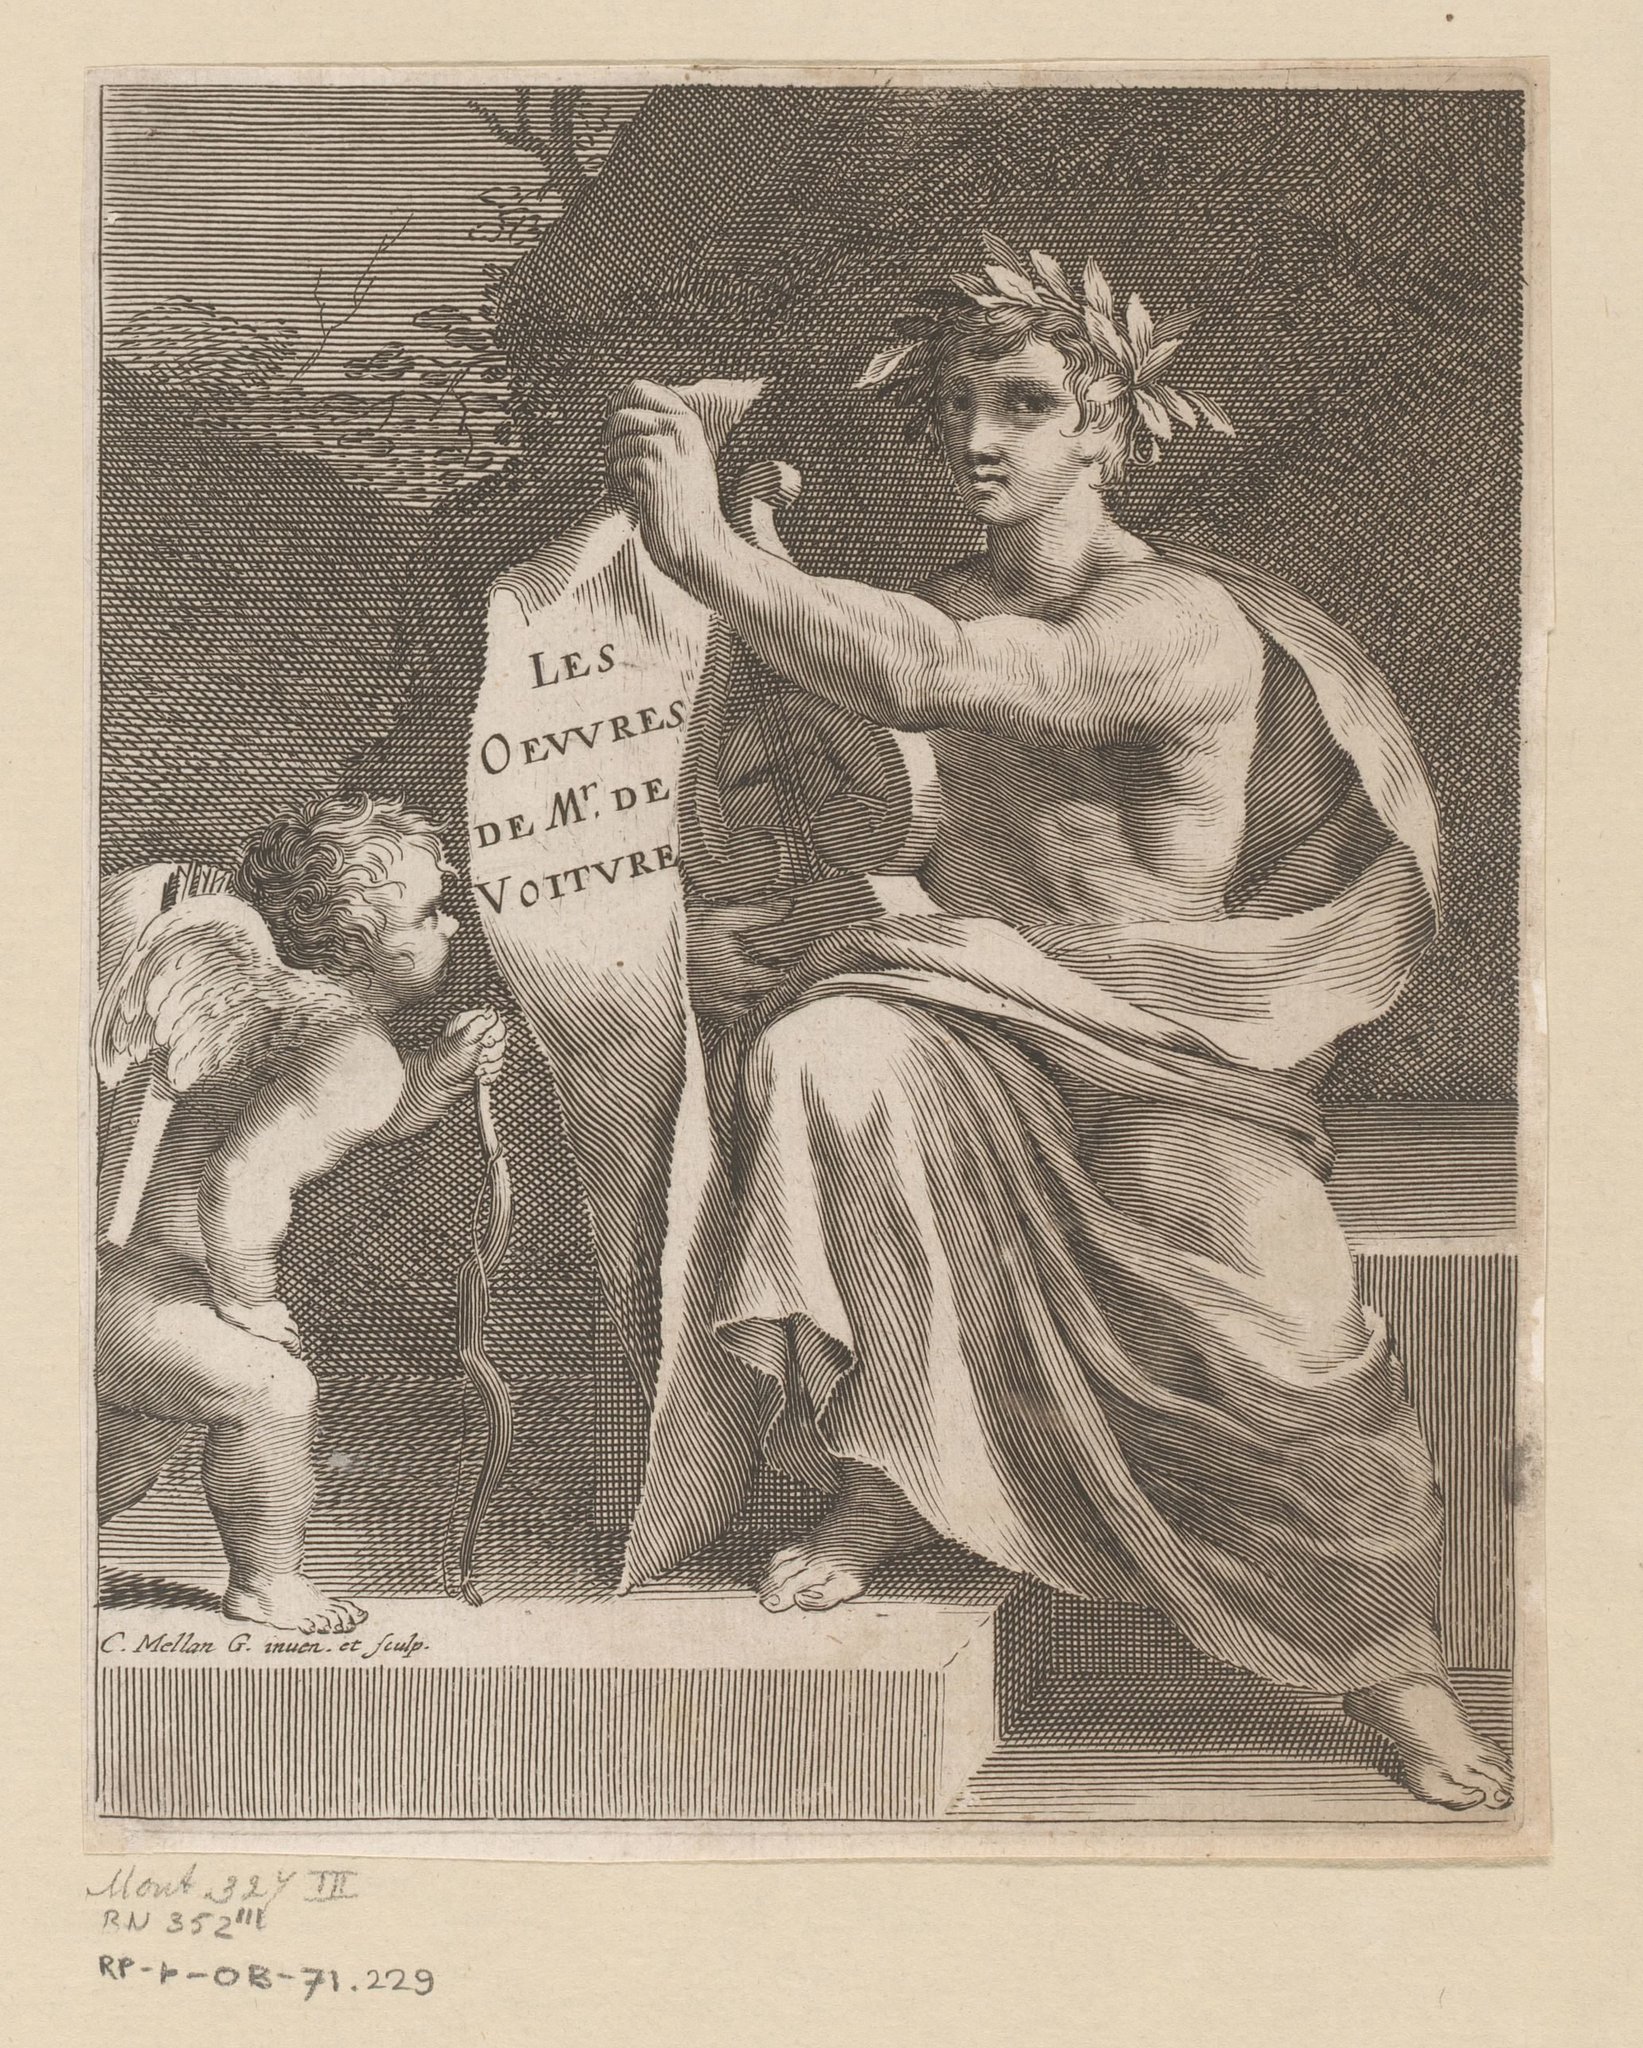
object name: print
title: Titelpagina voor: Vincent de Voiture, Les Oeuvres de Vincent de Voiture, 1650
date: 1650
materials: paper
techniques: engraving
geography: paris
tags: (story of) apollo (phoebus)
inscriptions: collector's mark: Lugt 240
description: Titelpagina voor: Voiture, Vincent de. Les Oeuvres de Vincent de Voiture. Parijs: Augustin Courbé, 1650.